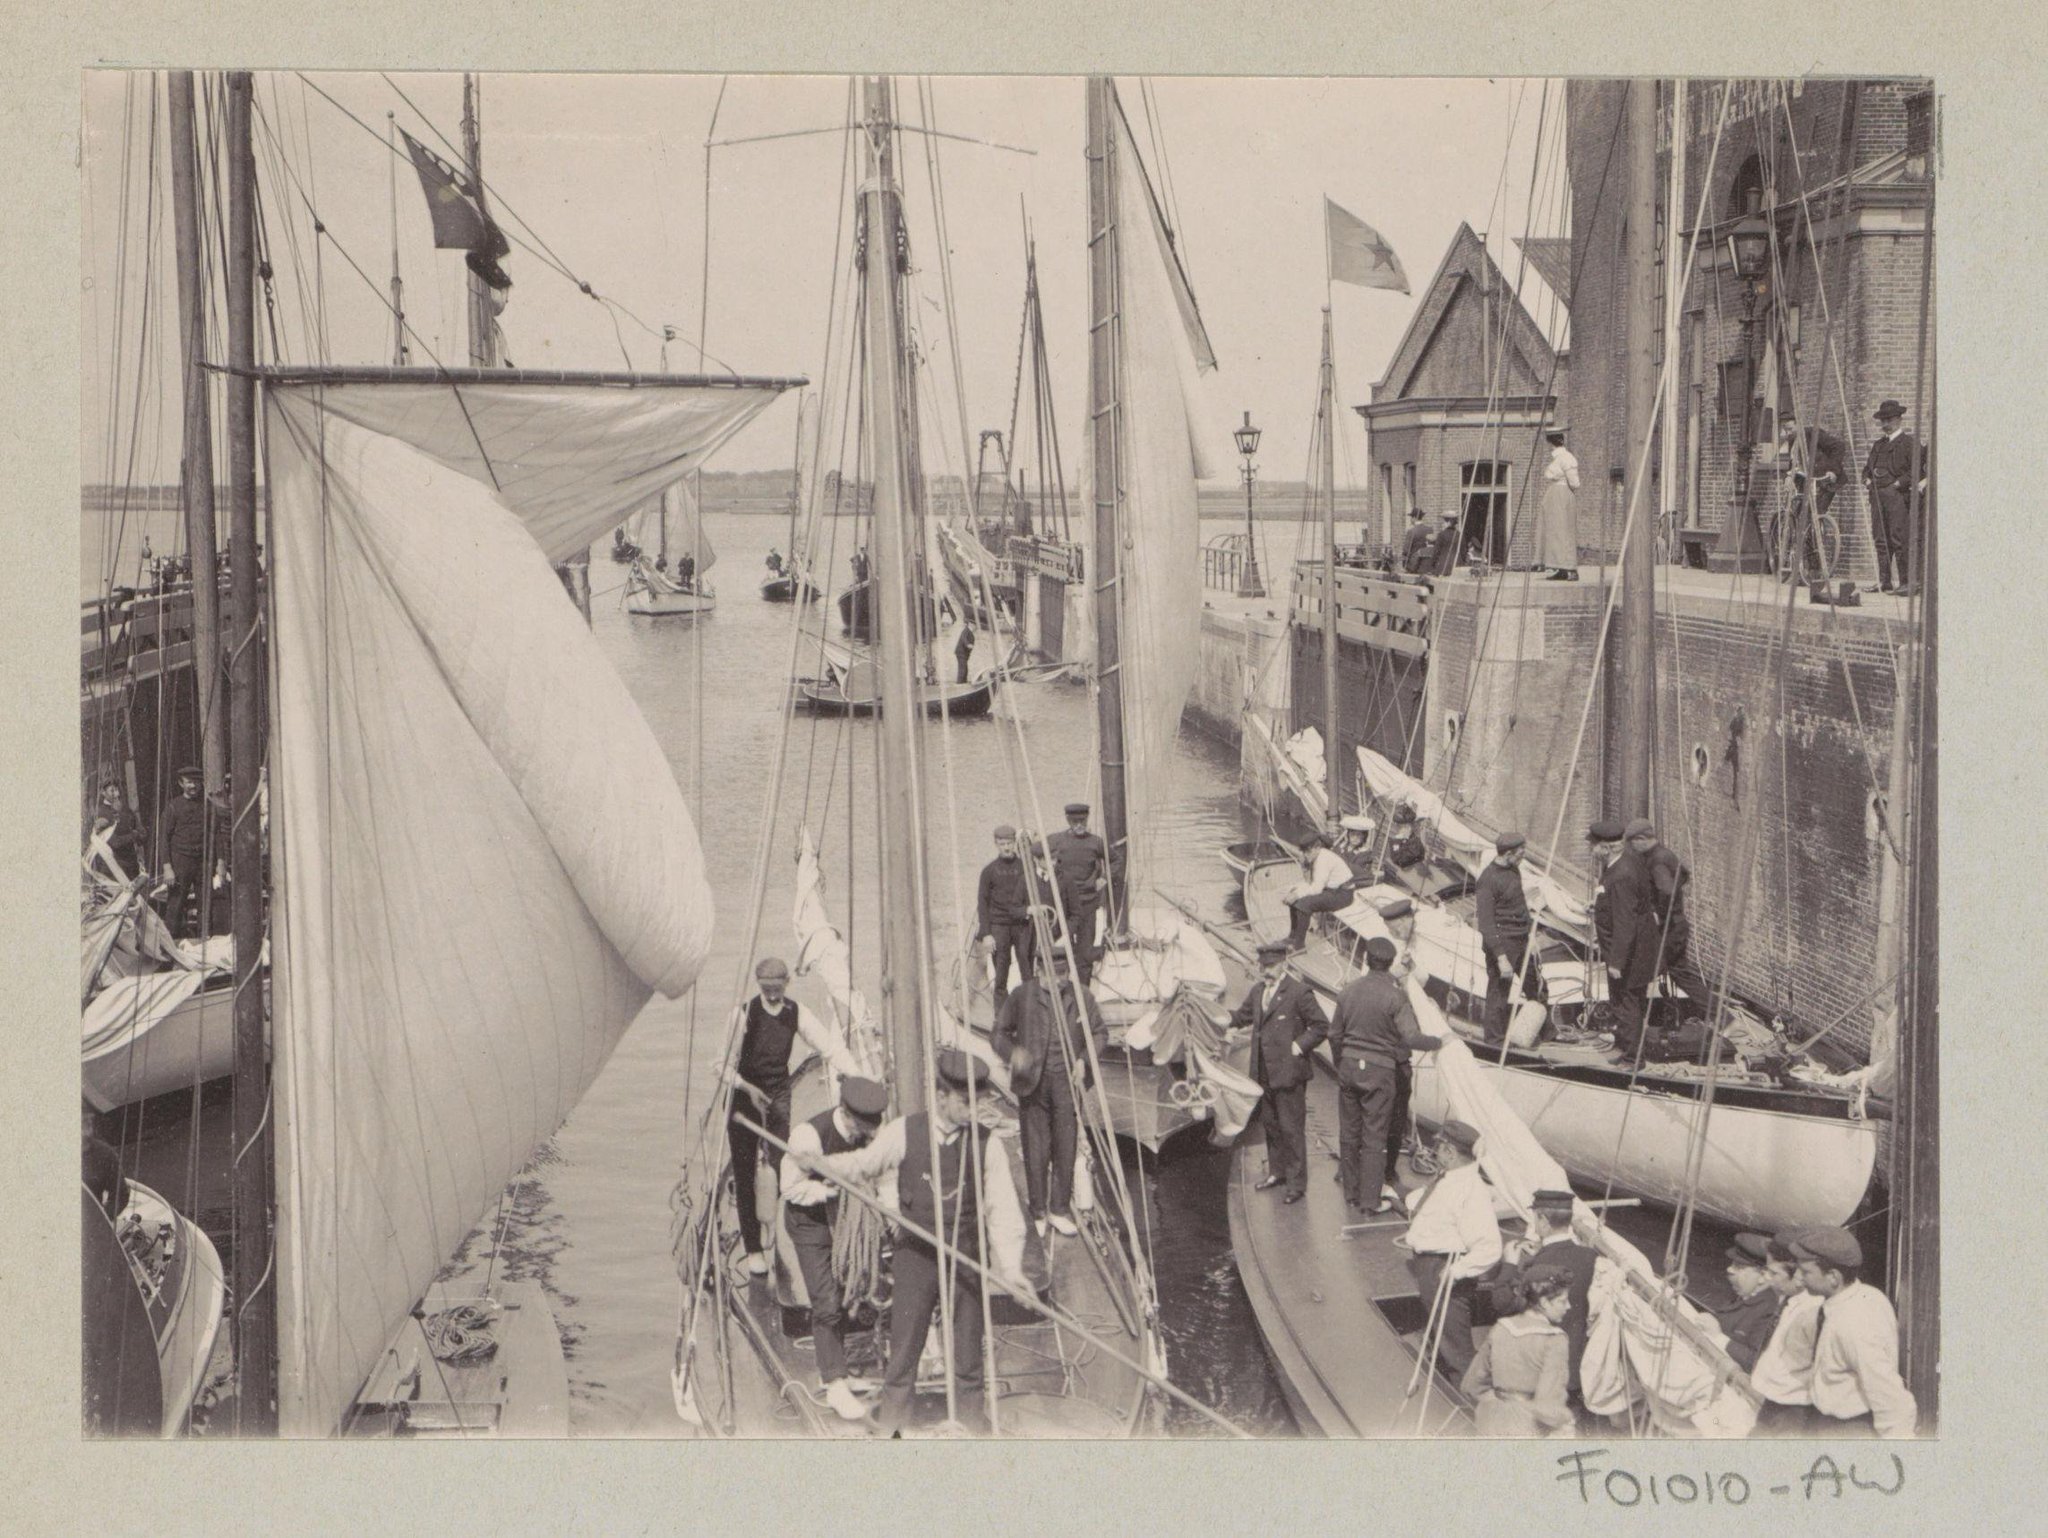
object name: photograph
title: Zeilschepen tijdens het schutten in een sluis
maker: Anonymous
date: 1900-1910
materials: photographic support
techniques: daylight paper print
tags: sluice, weir, sailing-ship, sailing-boat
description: Onderdeel van Familiealbum met onder meer foto's van Wijnhandel Kraaij & Co. Bordeaux-Amsterdam.